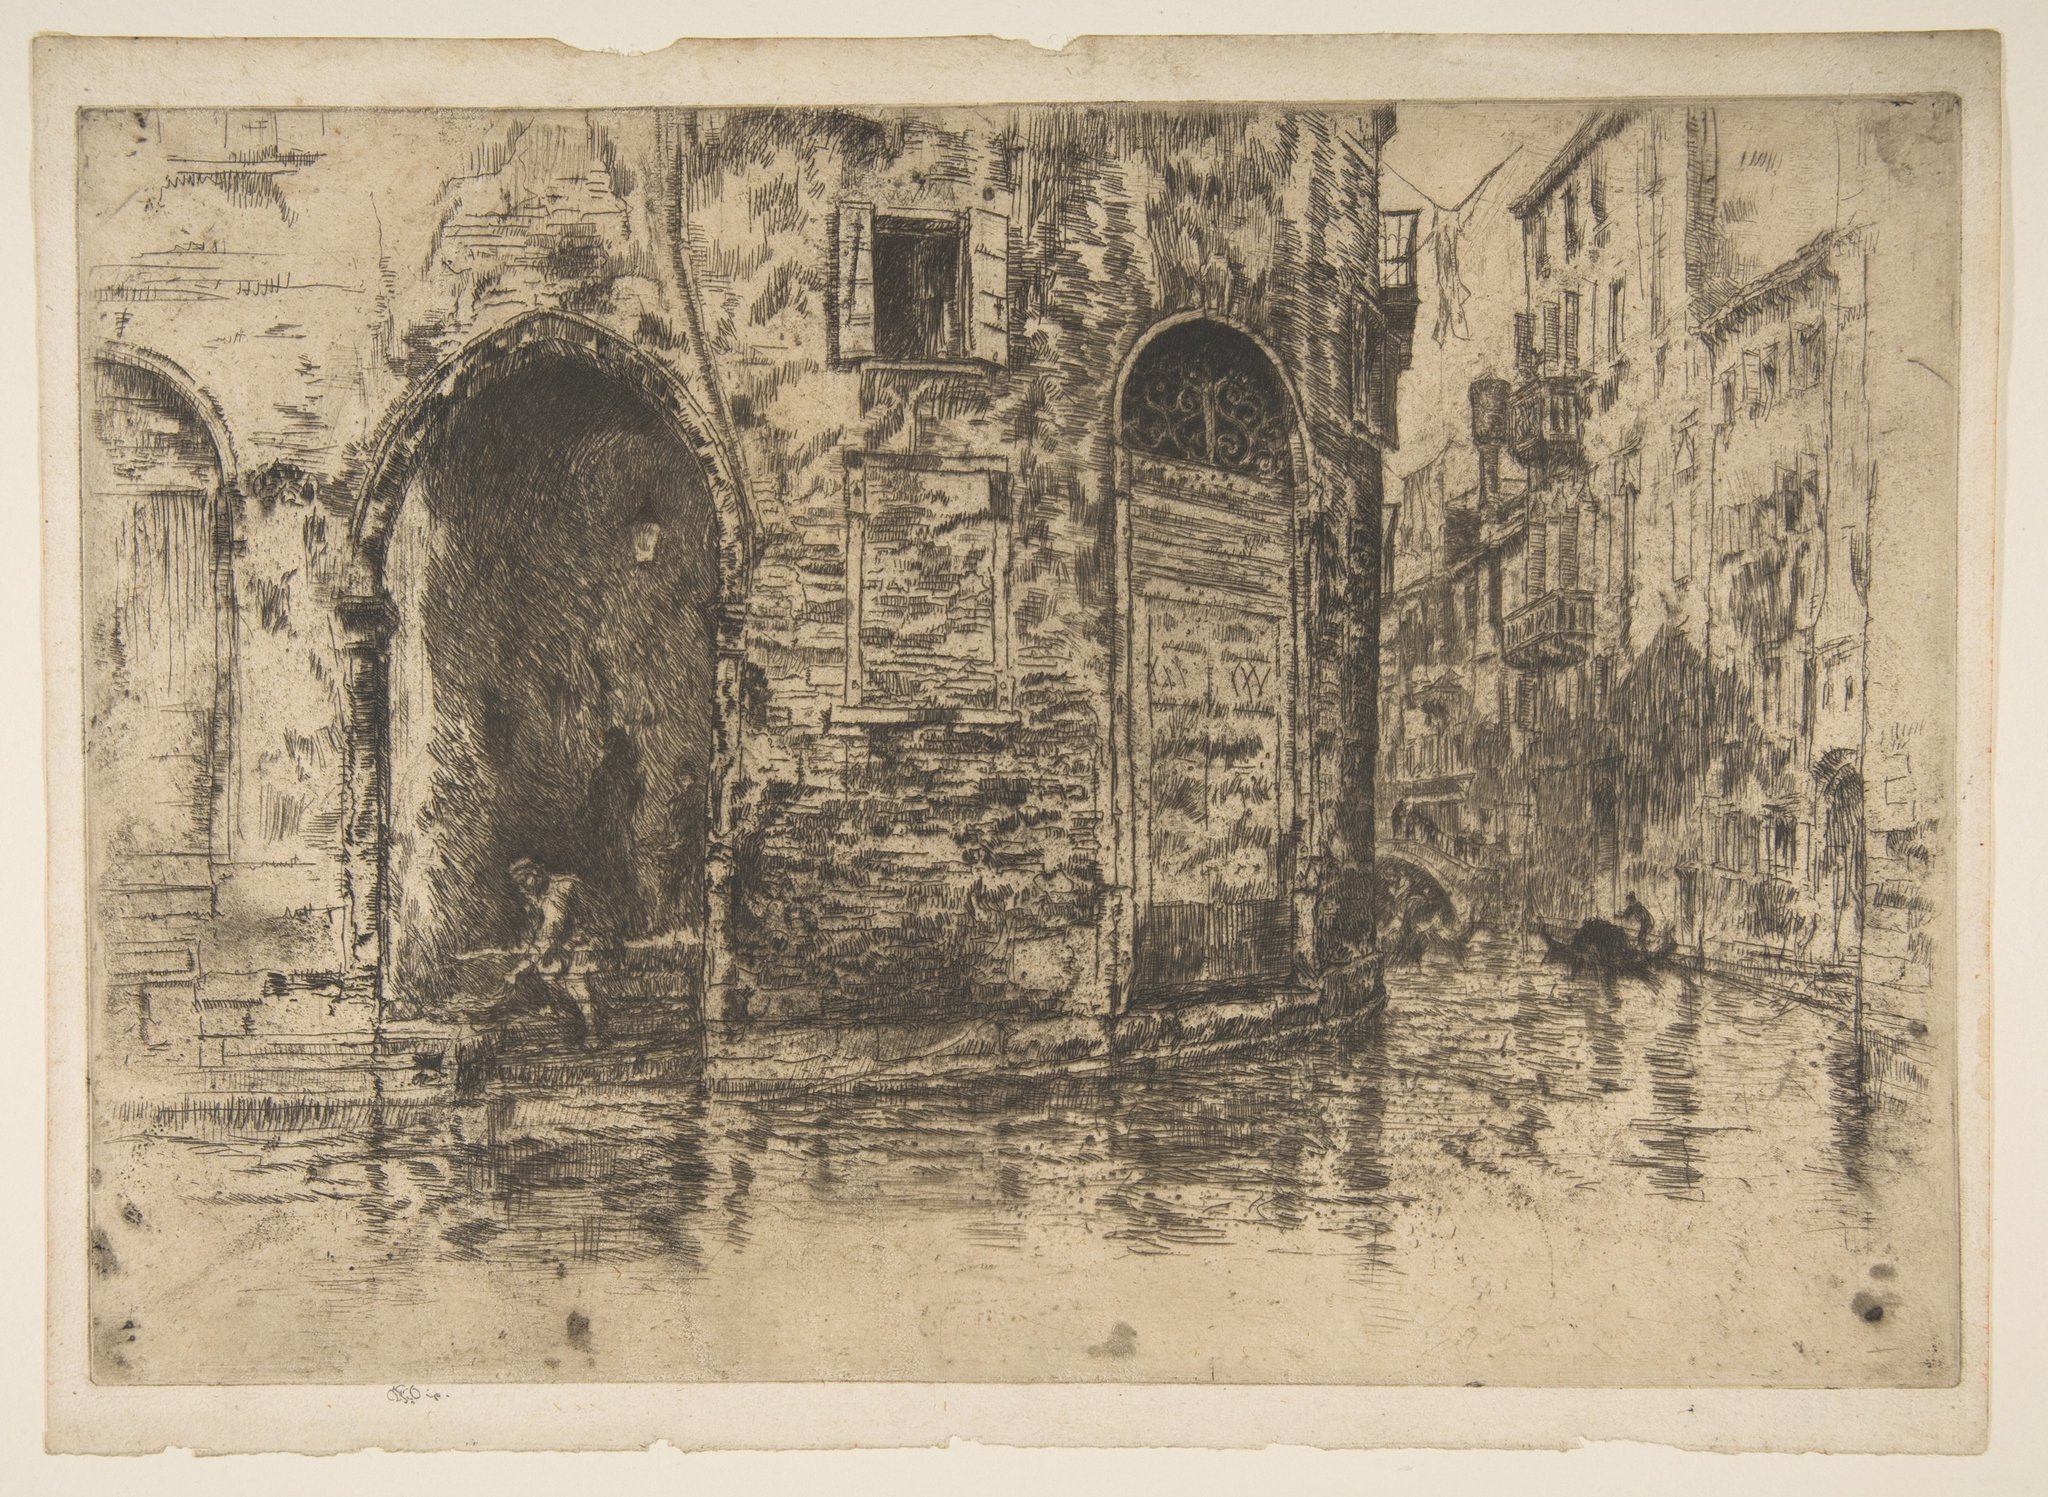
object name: print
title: Two Doorways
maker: james mcneill whistler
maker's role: artist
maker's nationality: american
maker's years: 1834-1903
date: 1879-1880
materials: ink, paper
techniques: drypoint, etching, printing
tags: buildings,doorways,canals,venice